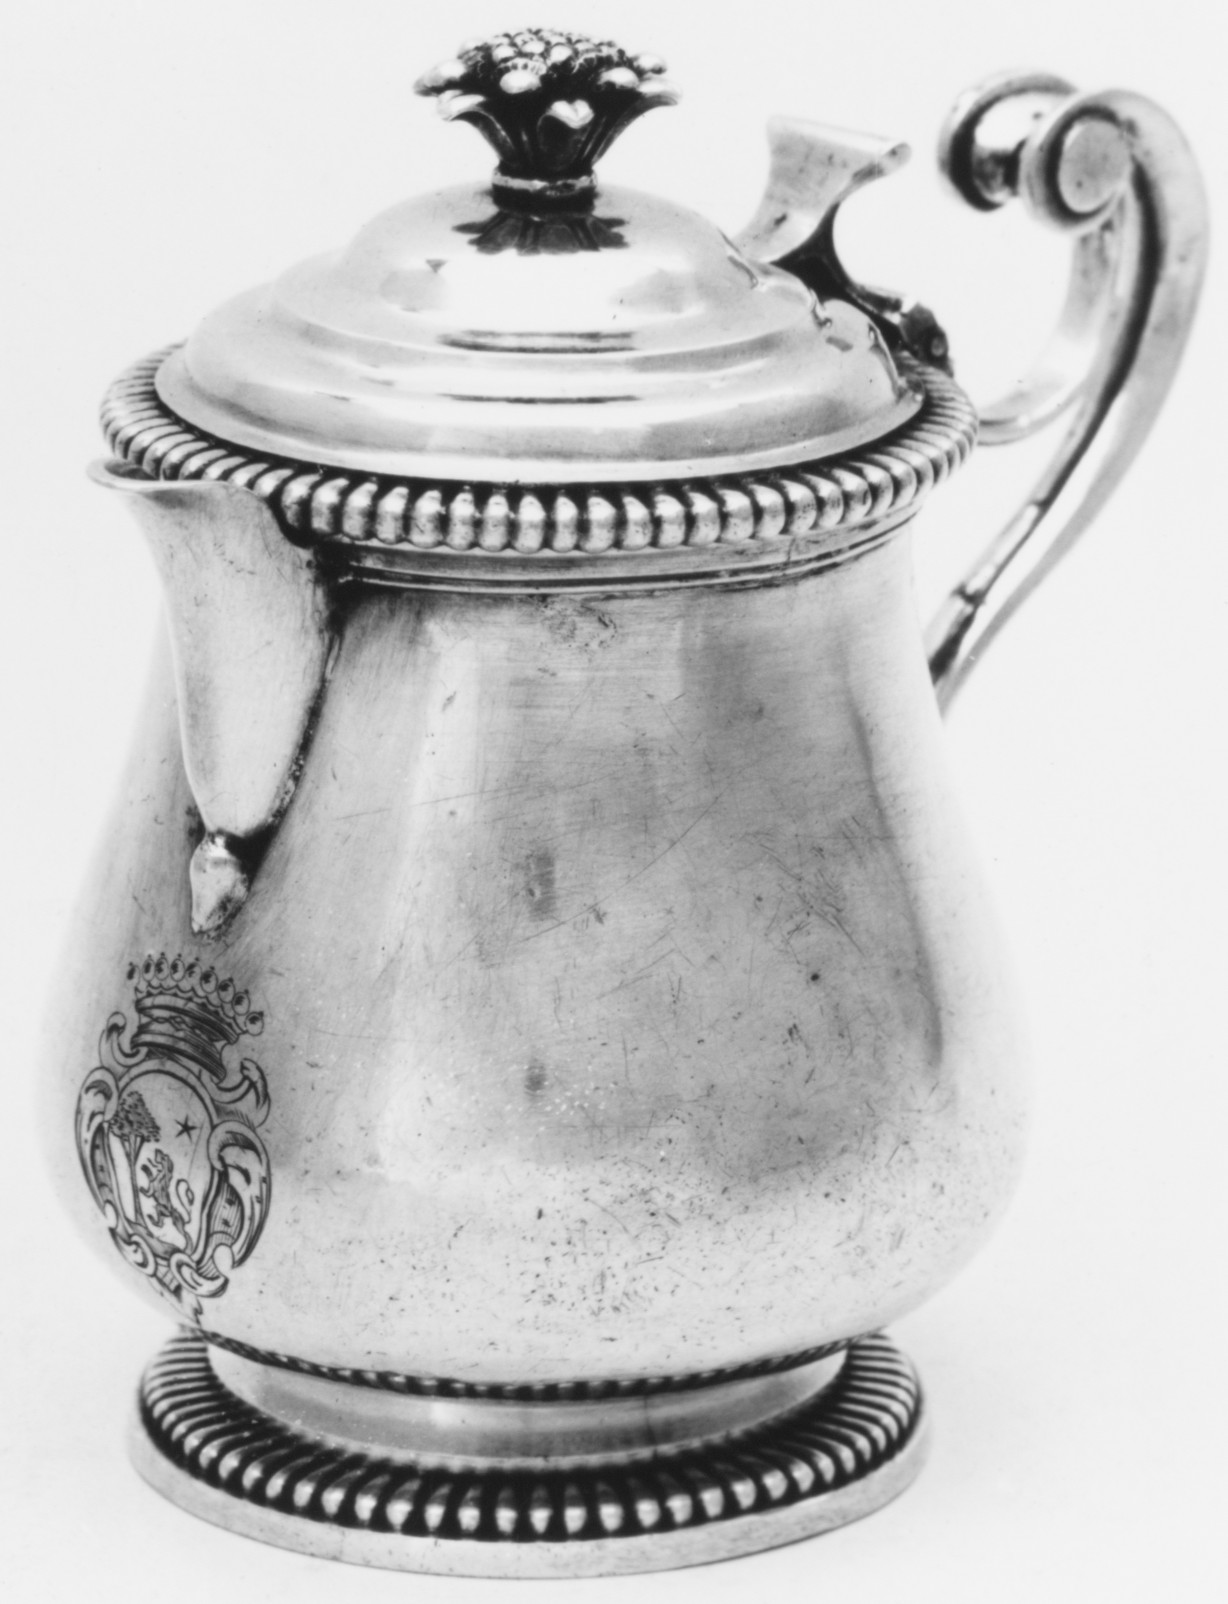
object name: mustard pot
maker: antoine moyset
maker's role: maker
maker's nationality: french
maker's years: 1664-1764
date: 1756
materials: silver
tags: coat of arms